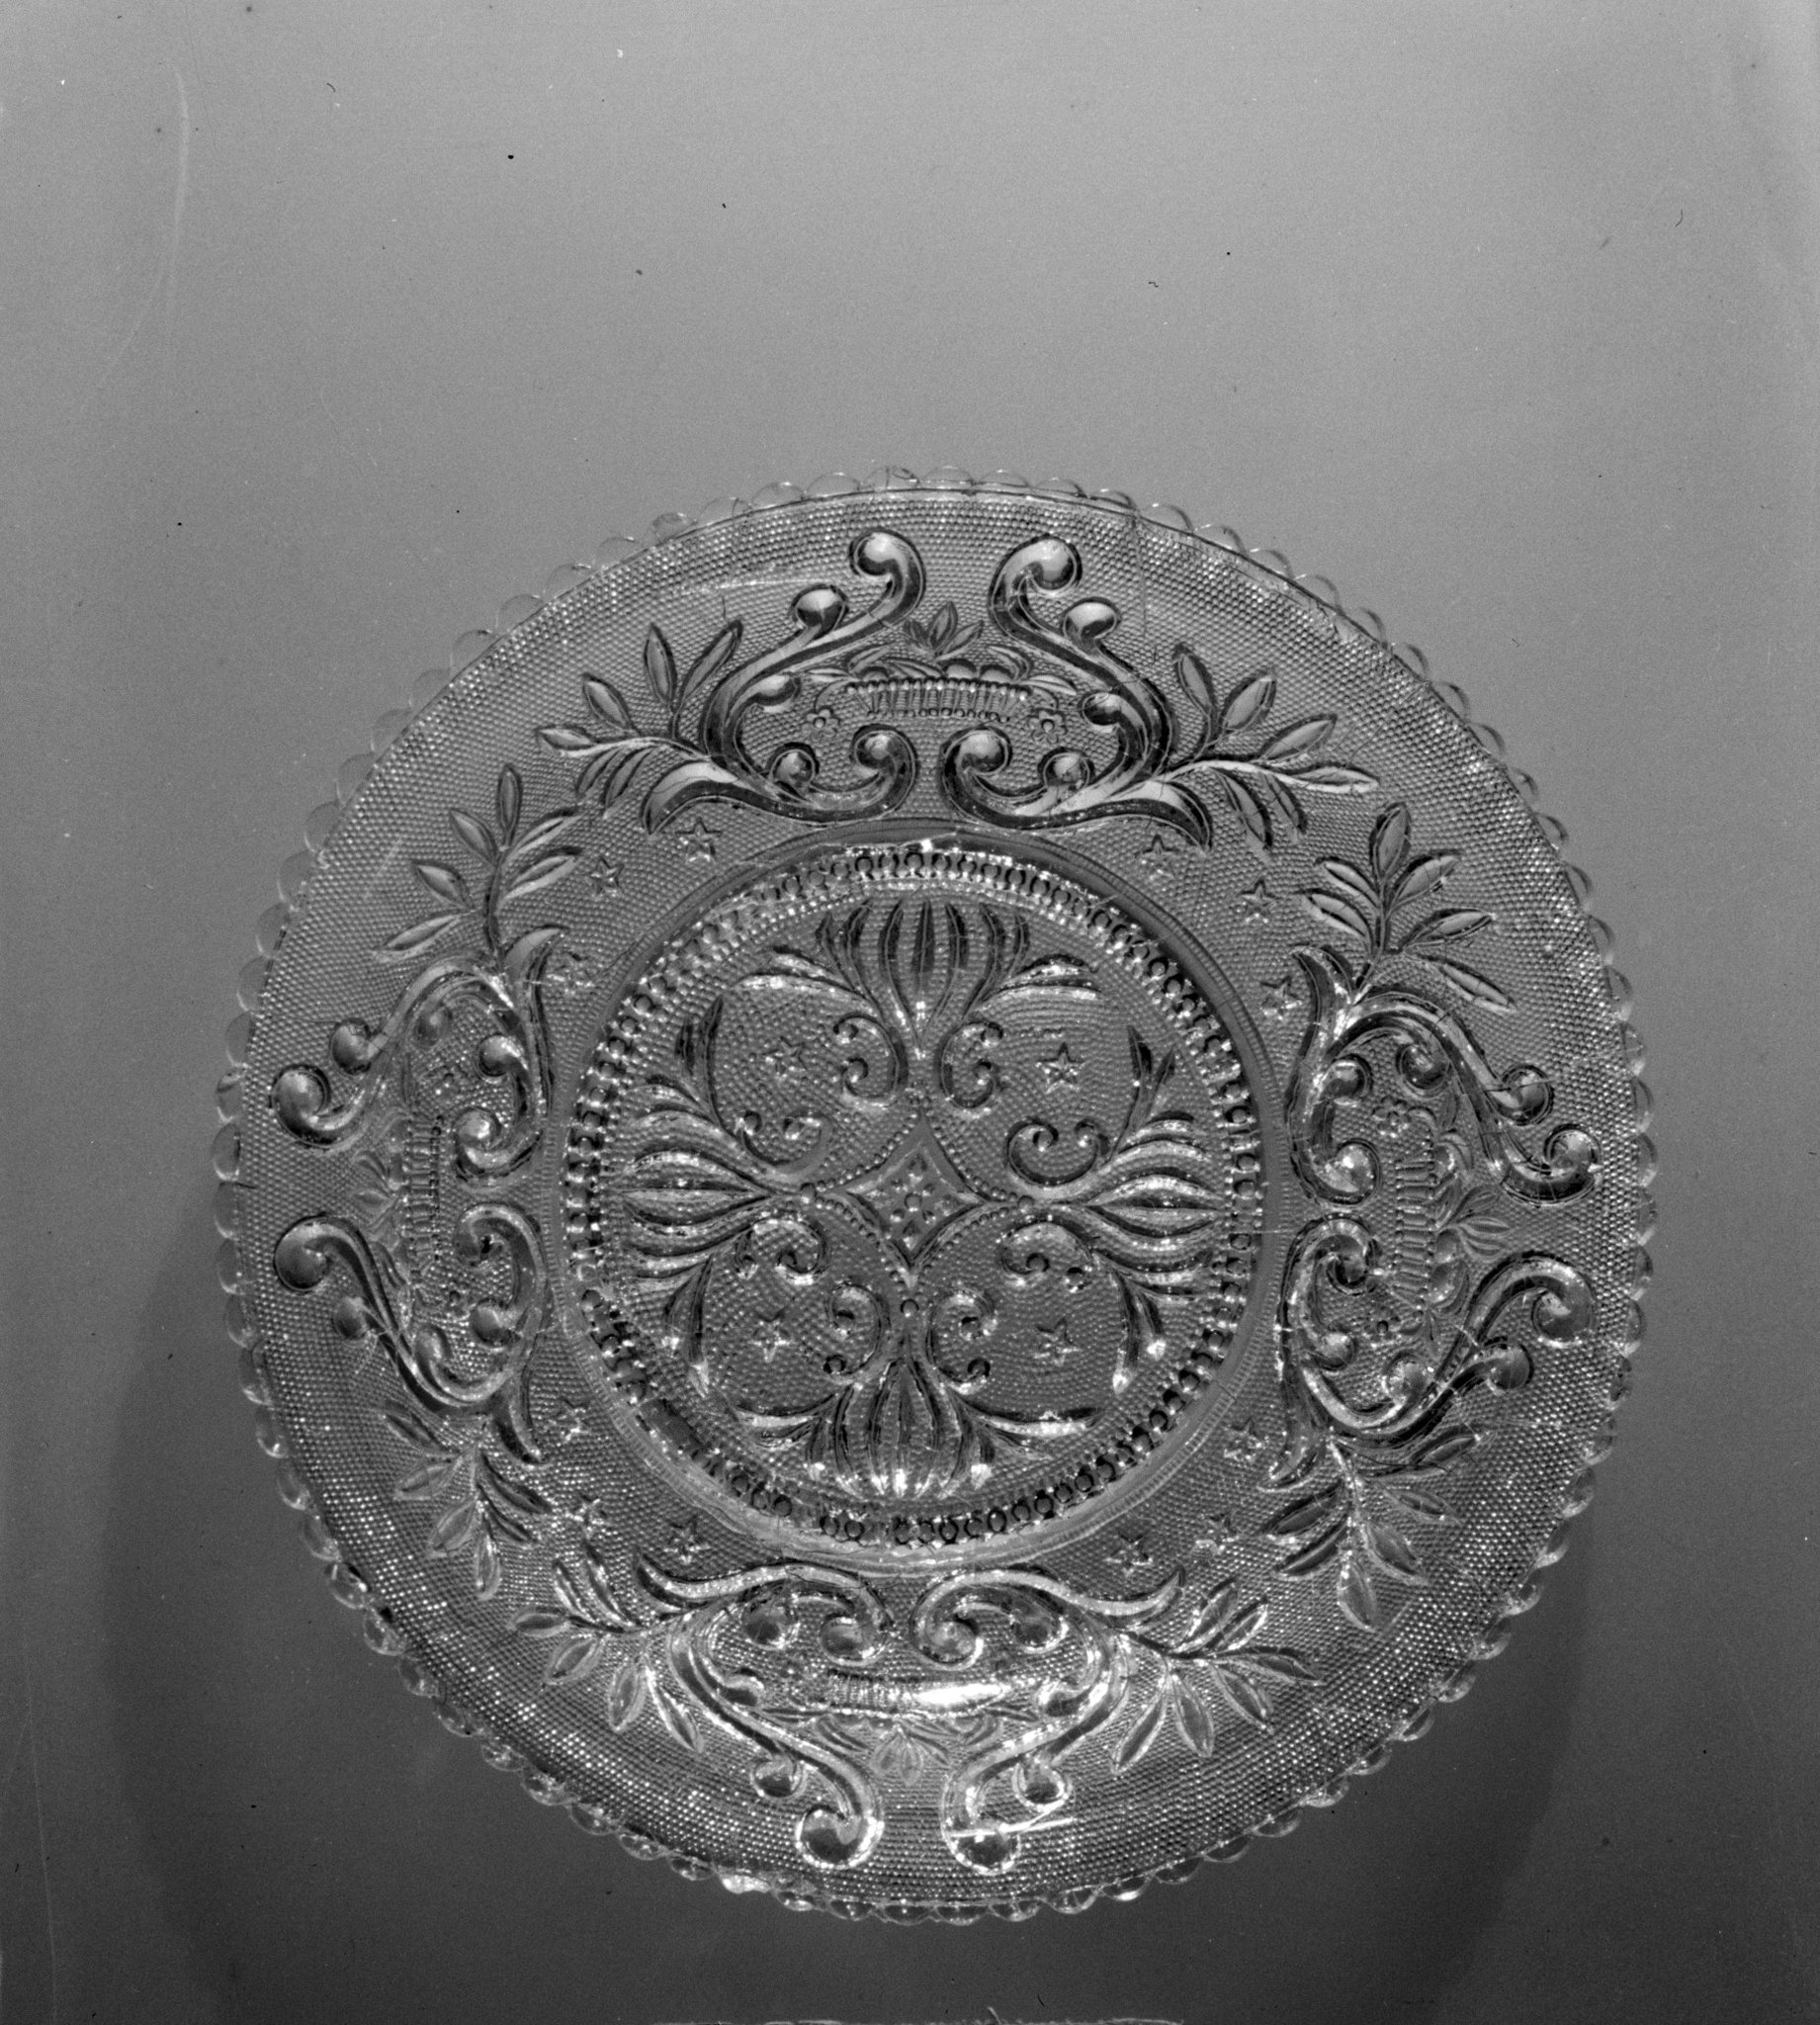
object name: bowl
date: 1835-1840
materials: glass